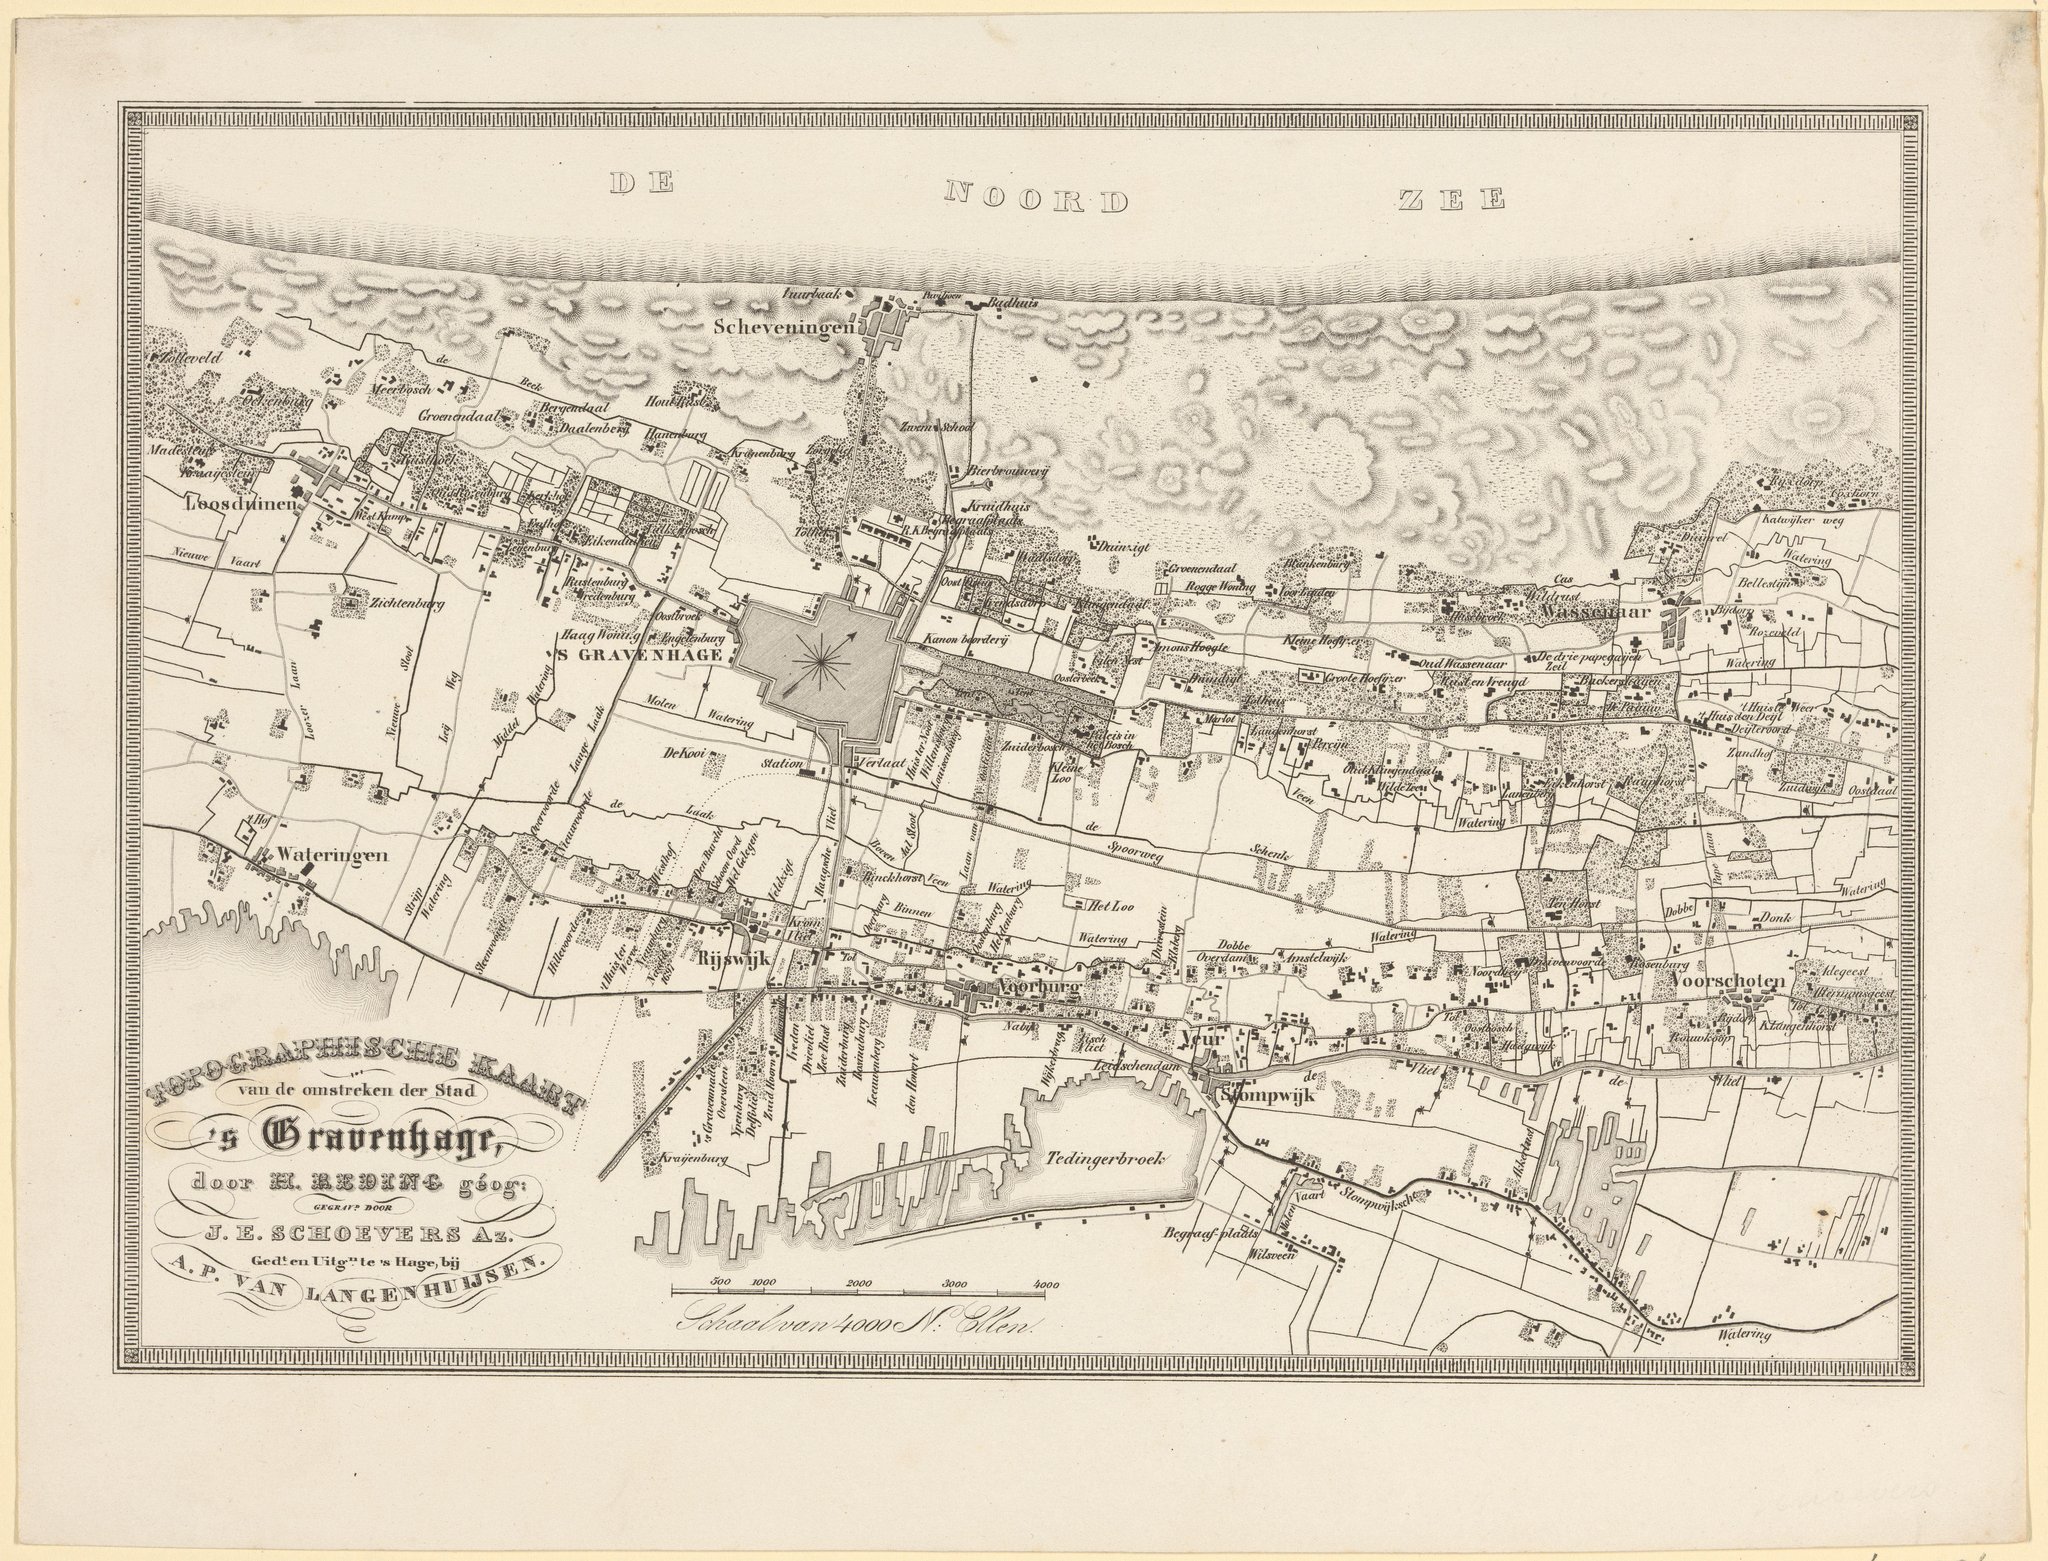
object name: print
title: Topografische kaart van de omstreken van 's-Gravenhage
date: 1830-1846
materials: paper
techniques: lithograph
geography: the hague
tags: maps, atlases, the hague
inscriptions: collector's mark: Lugt 2228